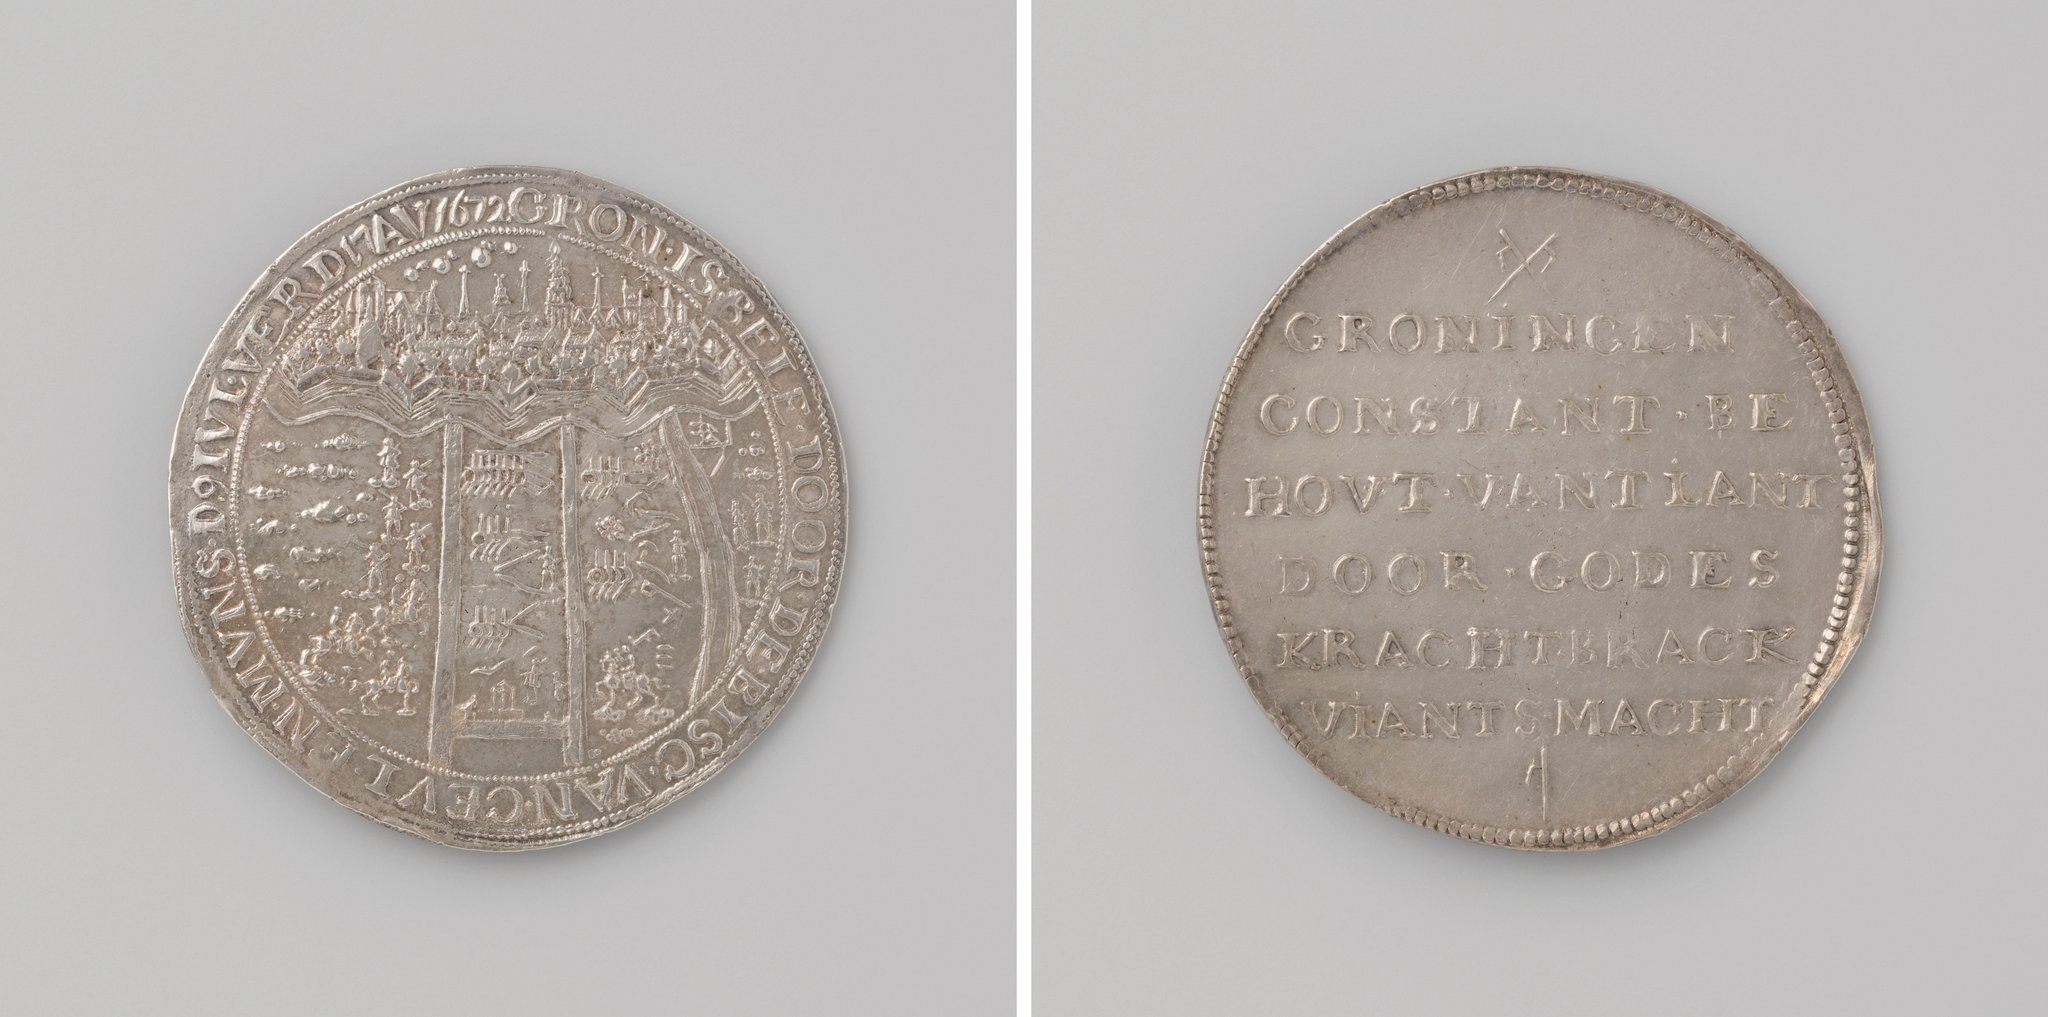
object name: history medal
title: Beleg van Groningen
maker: Anonymous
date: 1672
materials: silver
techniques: striking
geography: netherlands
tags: rampjaar (disaster year)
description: Zilveren penning. Voorzijde: gezicht op stad en belegeraars tijdens beschieting binnen omschrift. Keerzijde: opschrift.